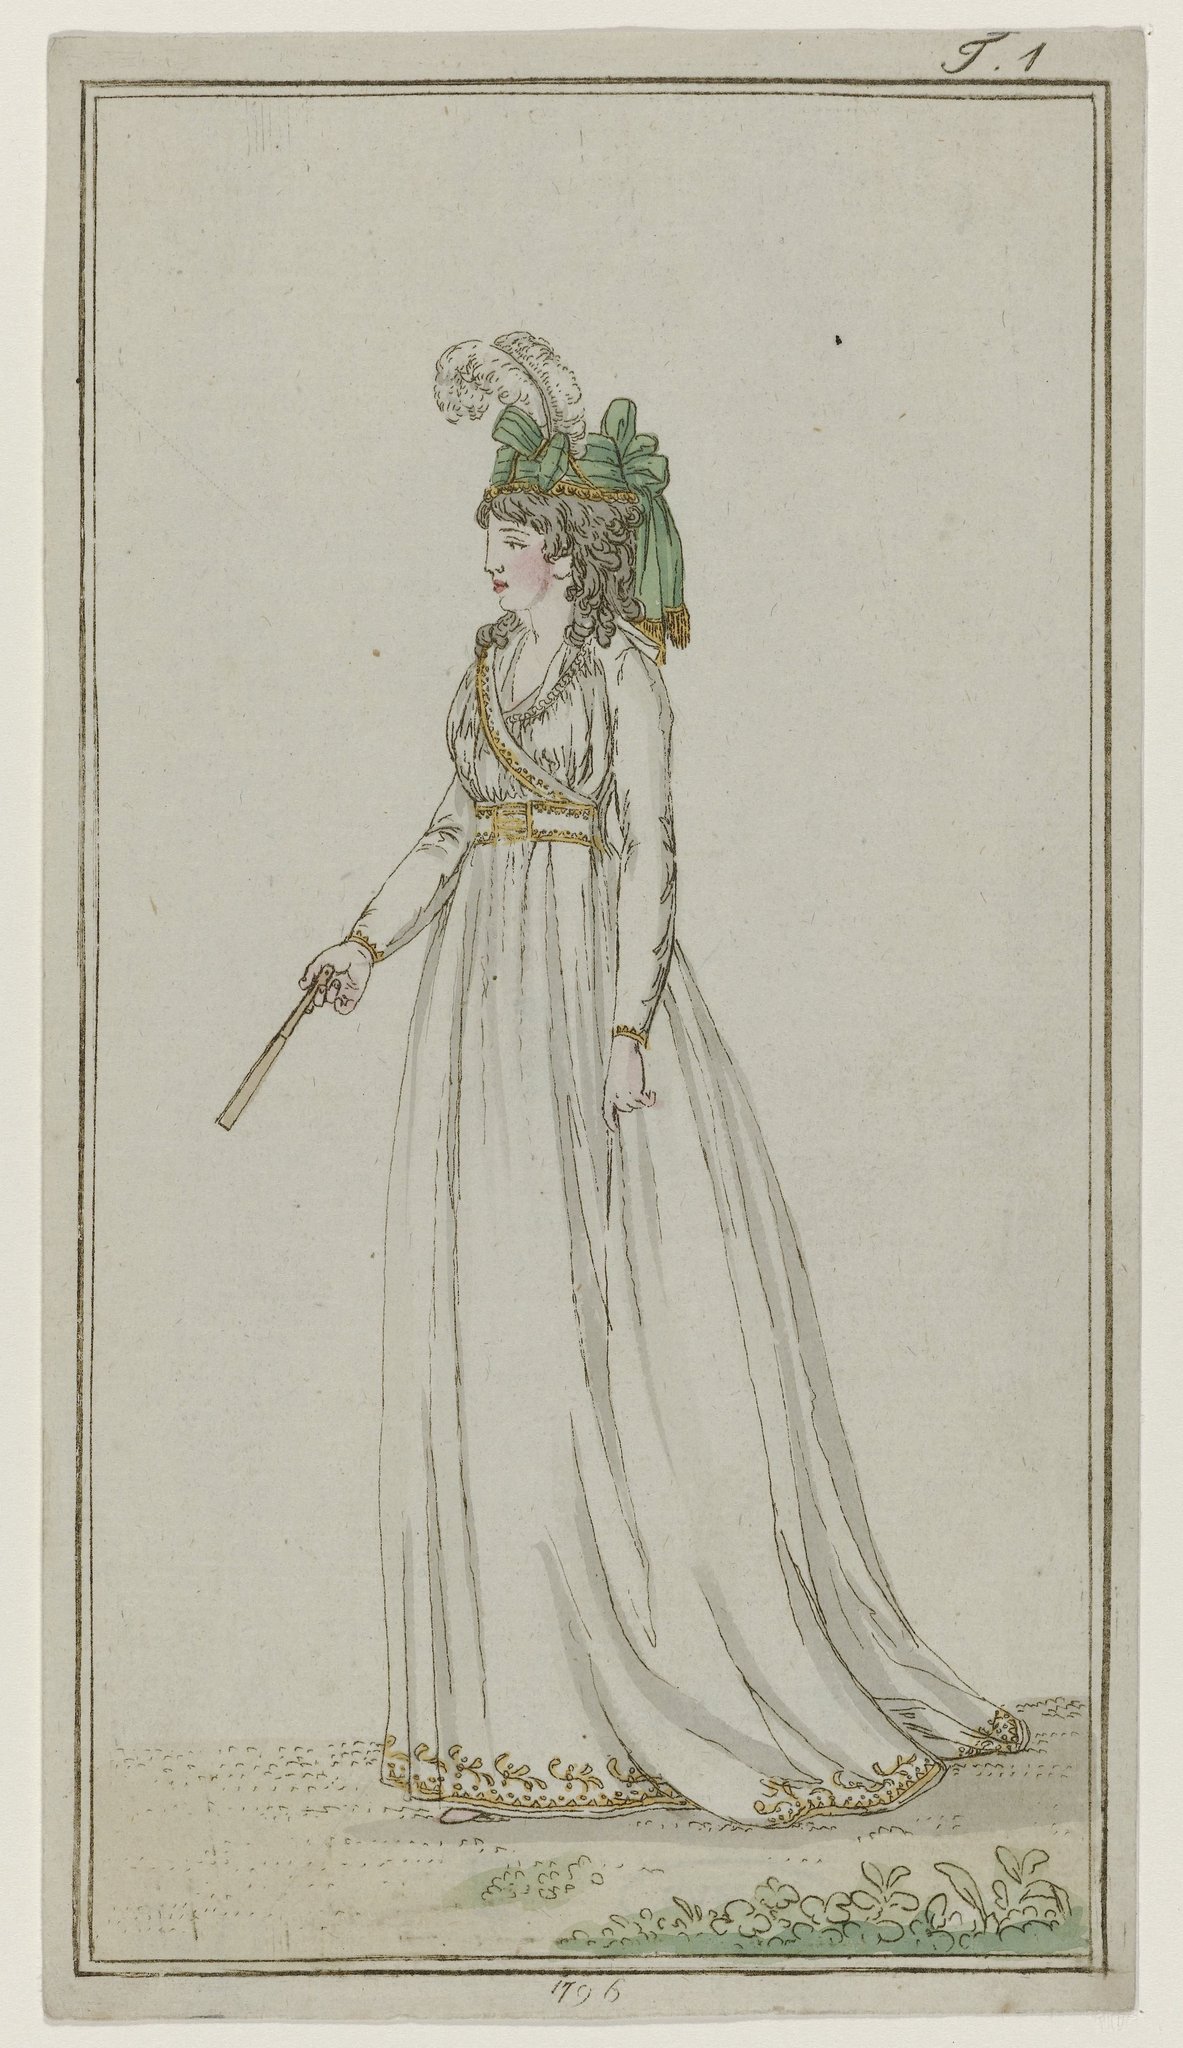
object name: fashion print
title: Journal des Luxus und der Moden, 1796, T 1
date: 1796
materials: paper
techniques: etching, hand coloring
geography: weimar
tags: head-gear: cap (+ women's clothes), fashion plates, shoes, sandals (+ women's clothes), dress, gown (+ women's clothes), fan (+ women's clothes)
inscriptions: date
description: Vrouw gekleed in een japon met lange mouwen, overslag en sleepje versierd met geometrisch motief. Accessoires: muts met struisveer, ceintuur(?), waaier. Prent uit het modetijdschrift Journal des Luxus und der Moden, uitgegeven door Friedrich Justin Bertuch en Georg Melchior Kraus, Weimar, 1786-1826.